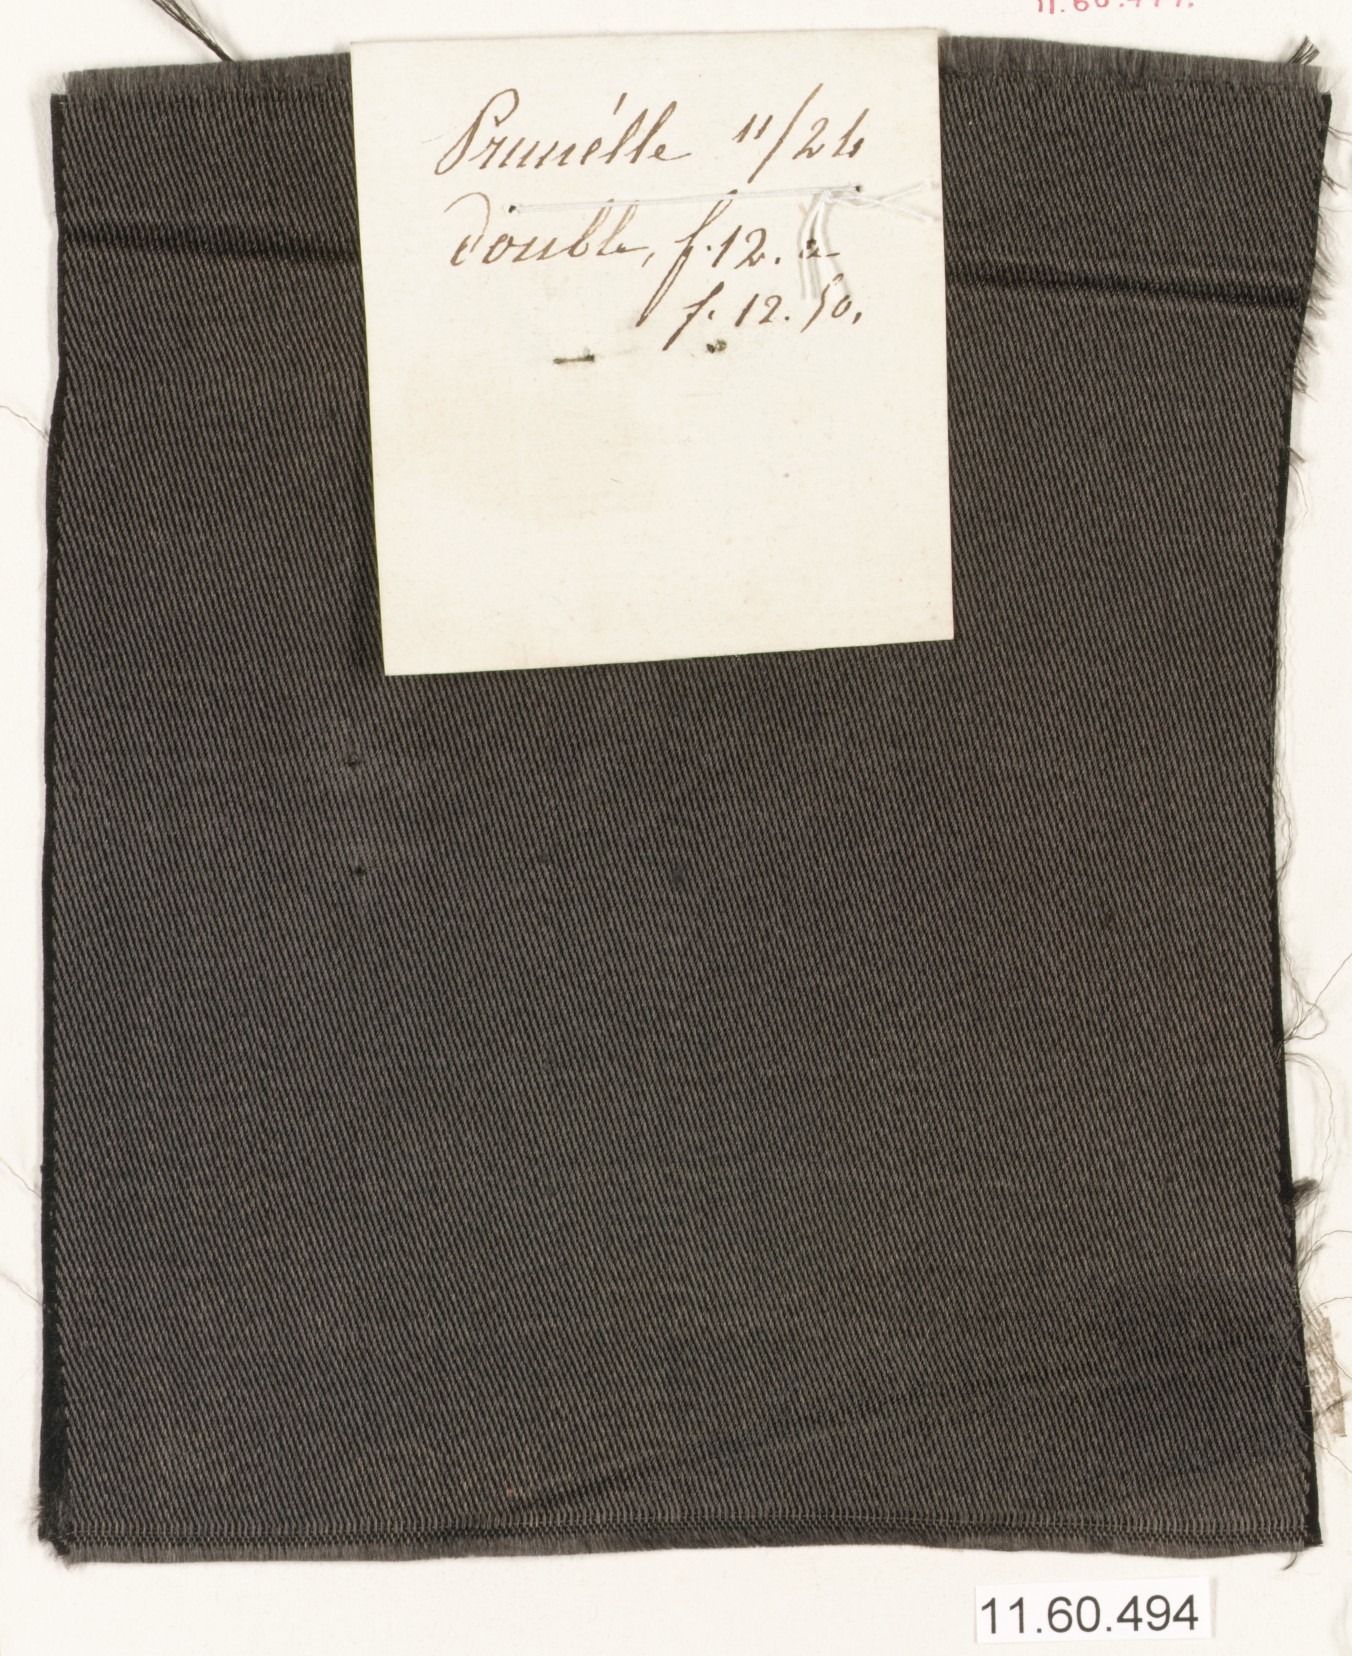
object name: sample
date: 1801-1850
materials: silk